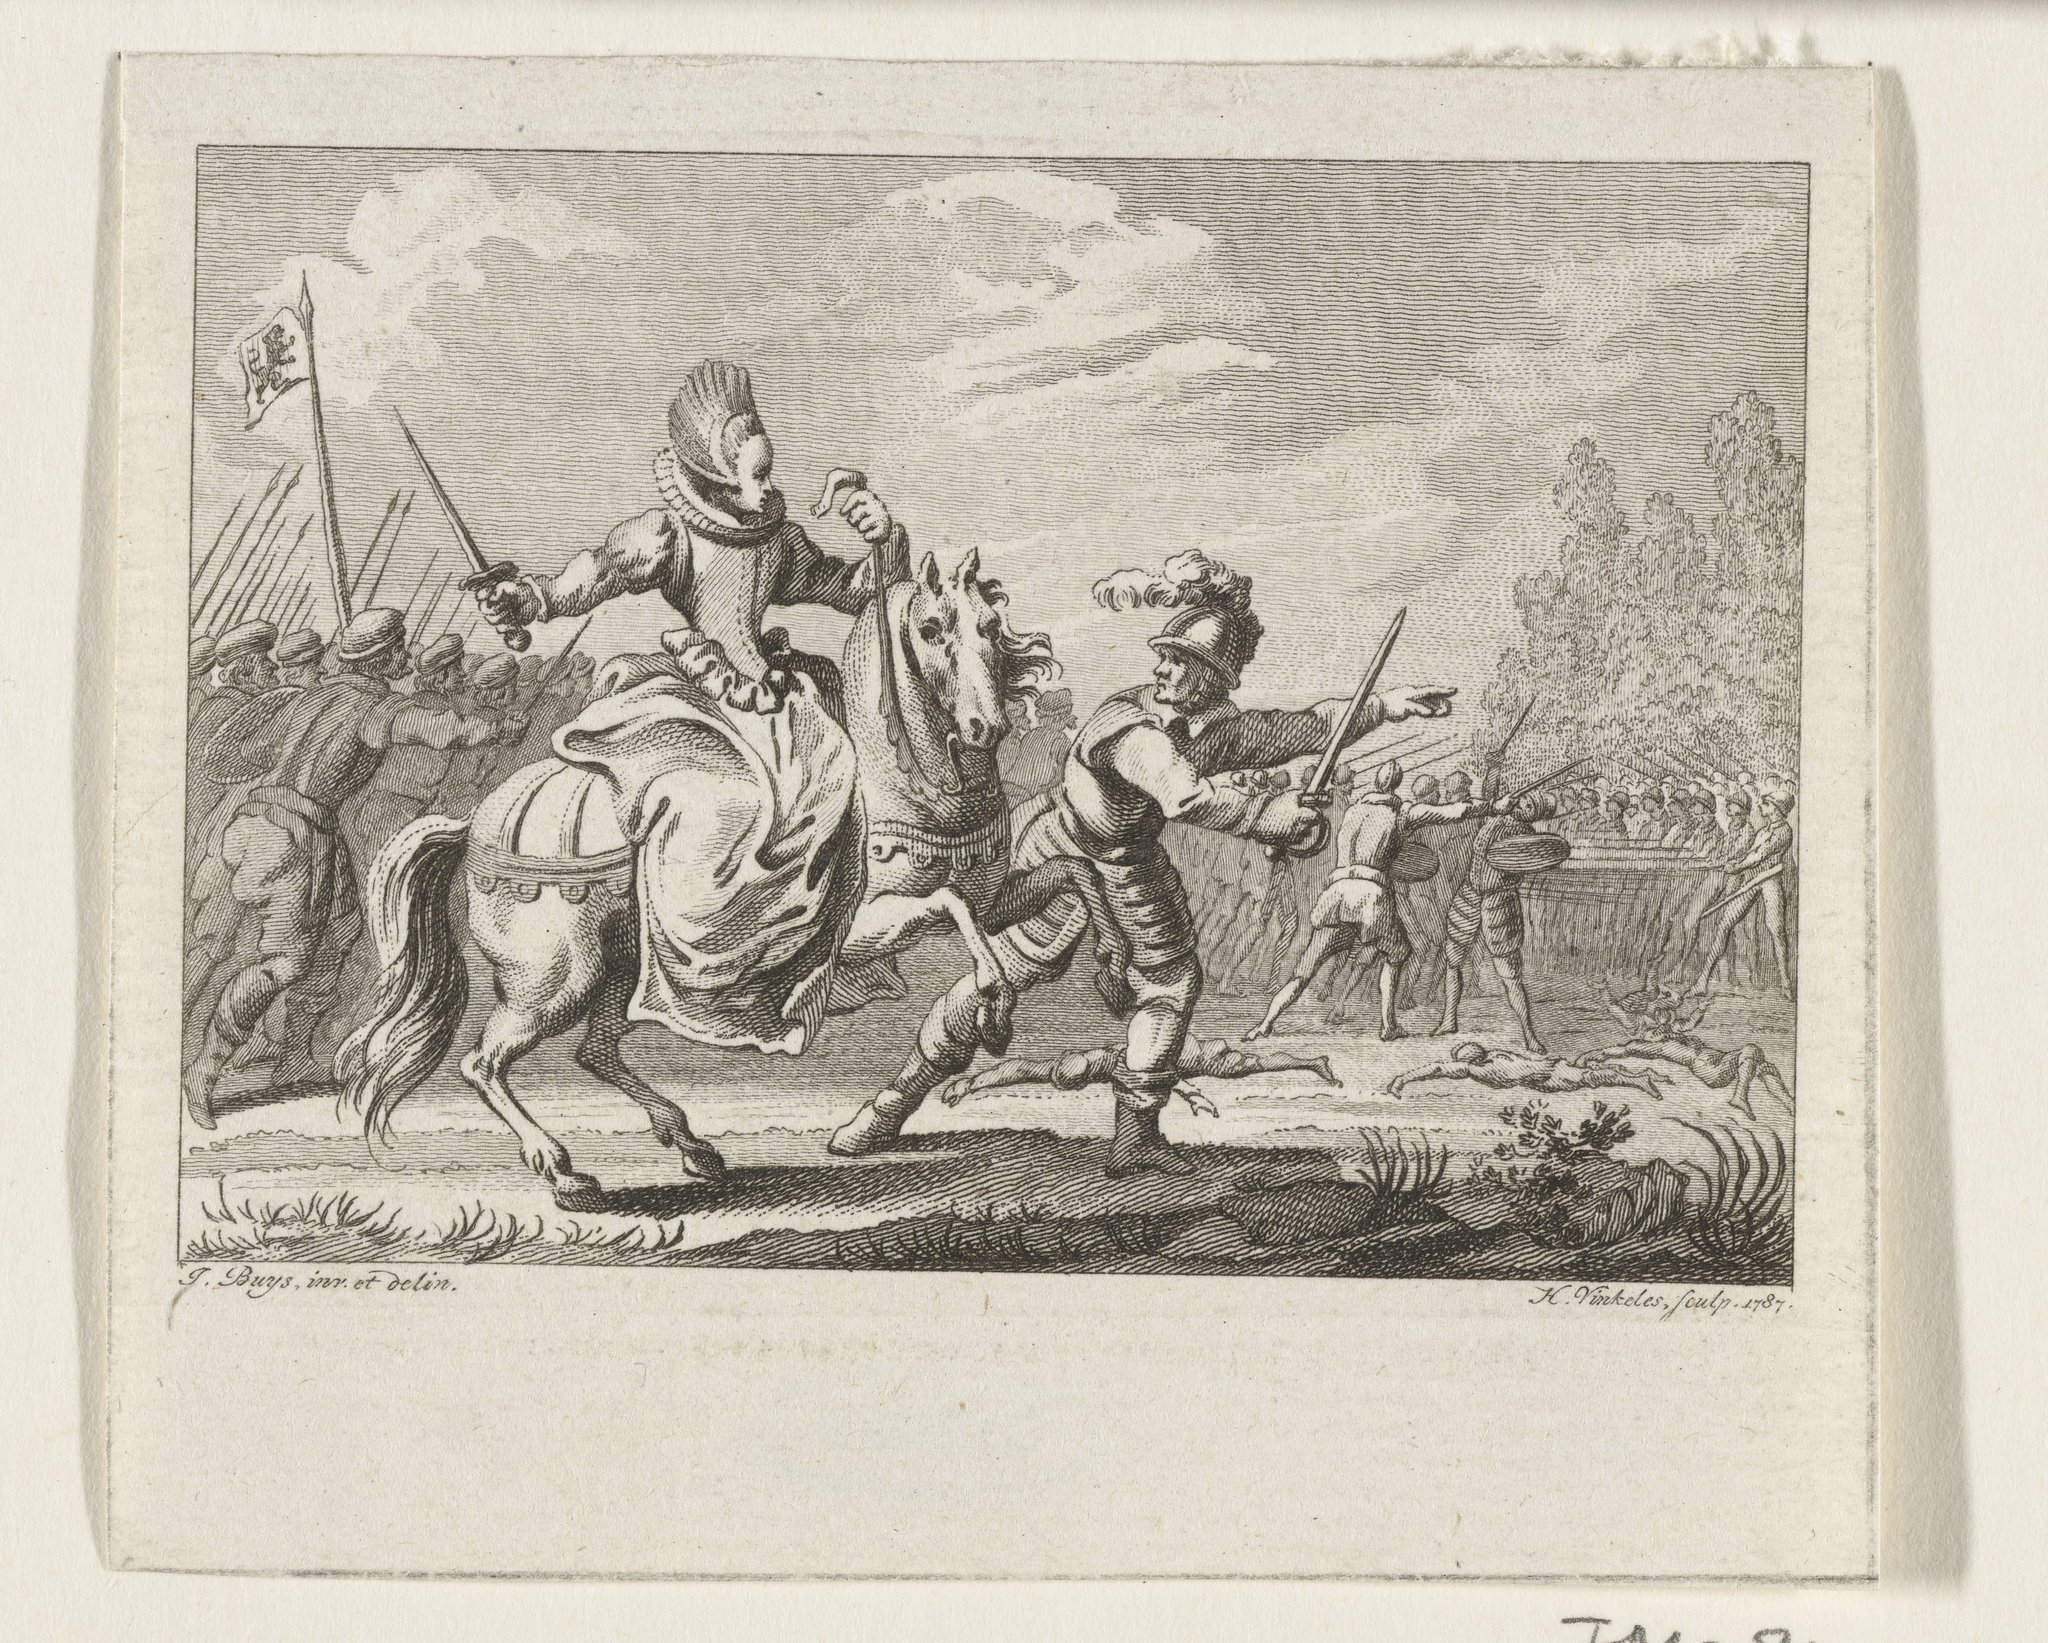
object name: print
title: Jacoba van Beieren stelt zich aan het hoofd van de Hoeken, ca. 1430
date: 1787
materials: paper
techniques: etching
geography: netherlands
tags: jacoba of bavaria (countess of hainaut), battle, fighting in general, netherlands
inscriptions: date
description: Illustratie gebruikt in: J.F. Martinet, Het vereenigd Nederland, J. Allart, Amsterdam 1788, p. 94/95.